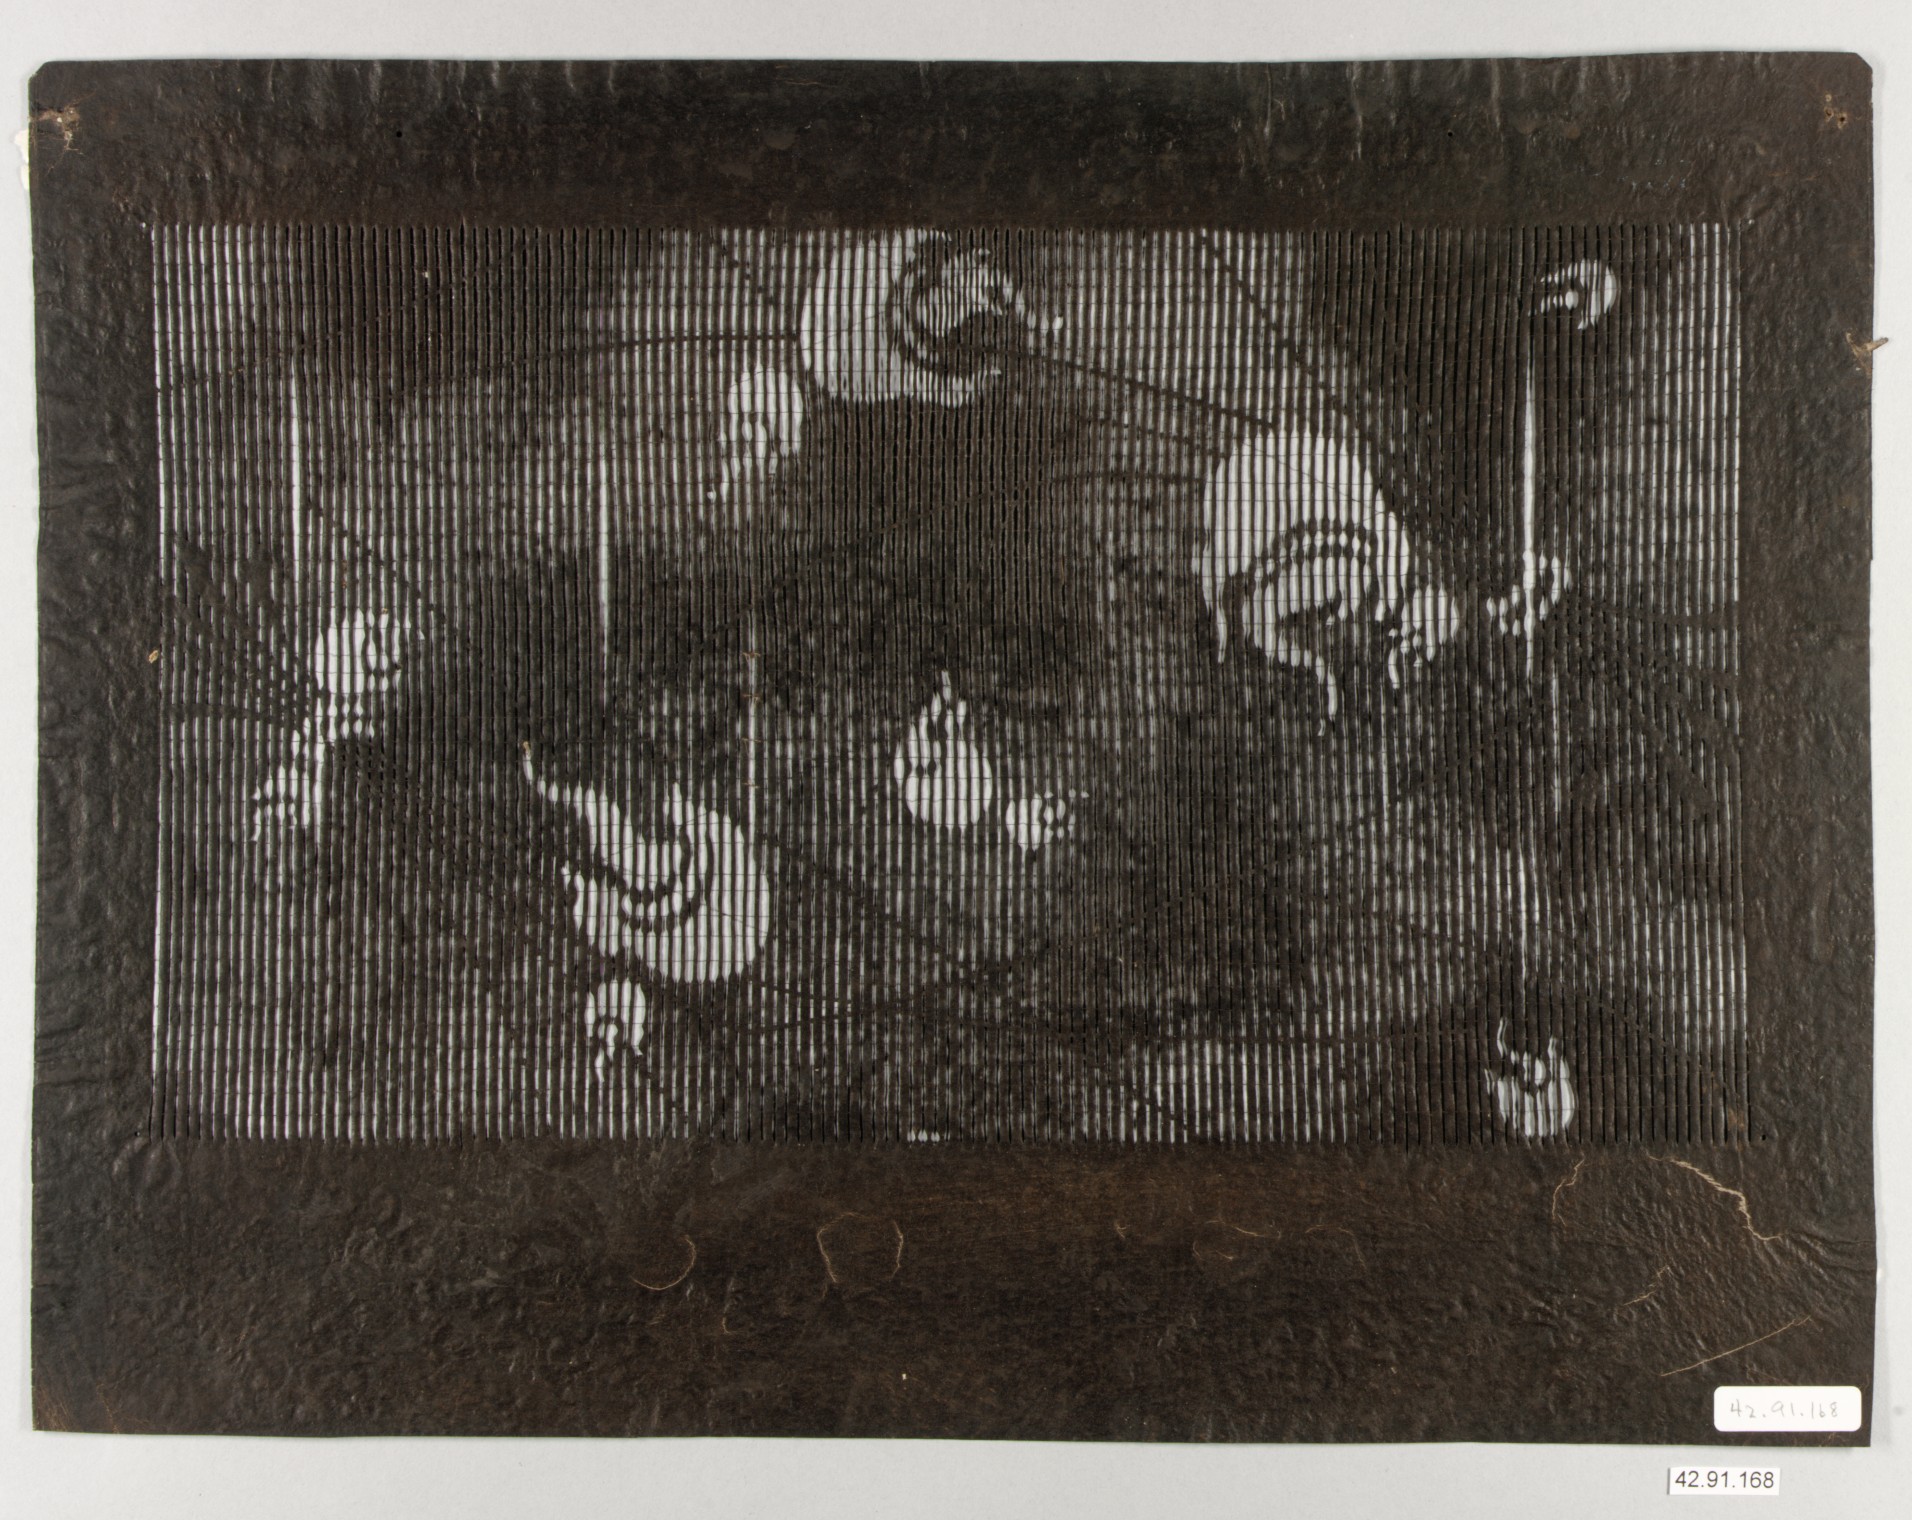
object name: stencil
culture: japanese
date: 1801-1900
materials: paper